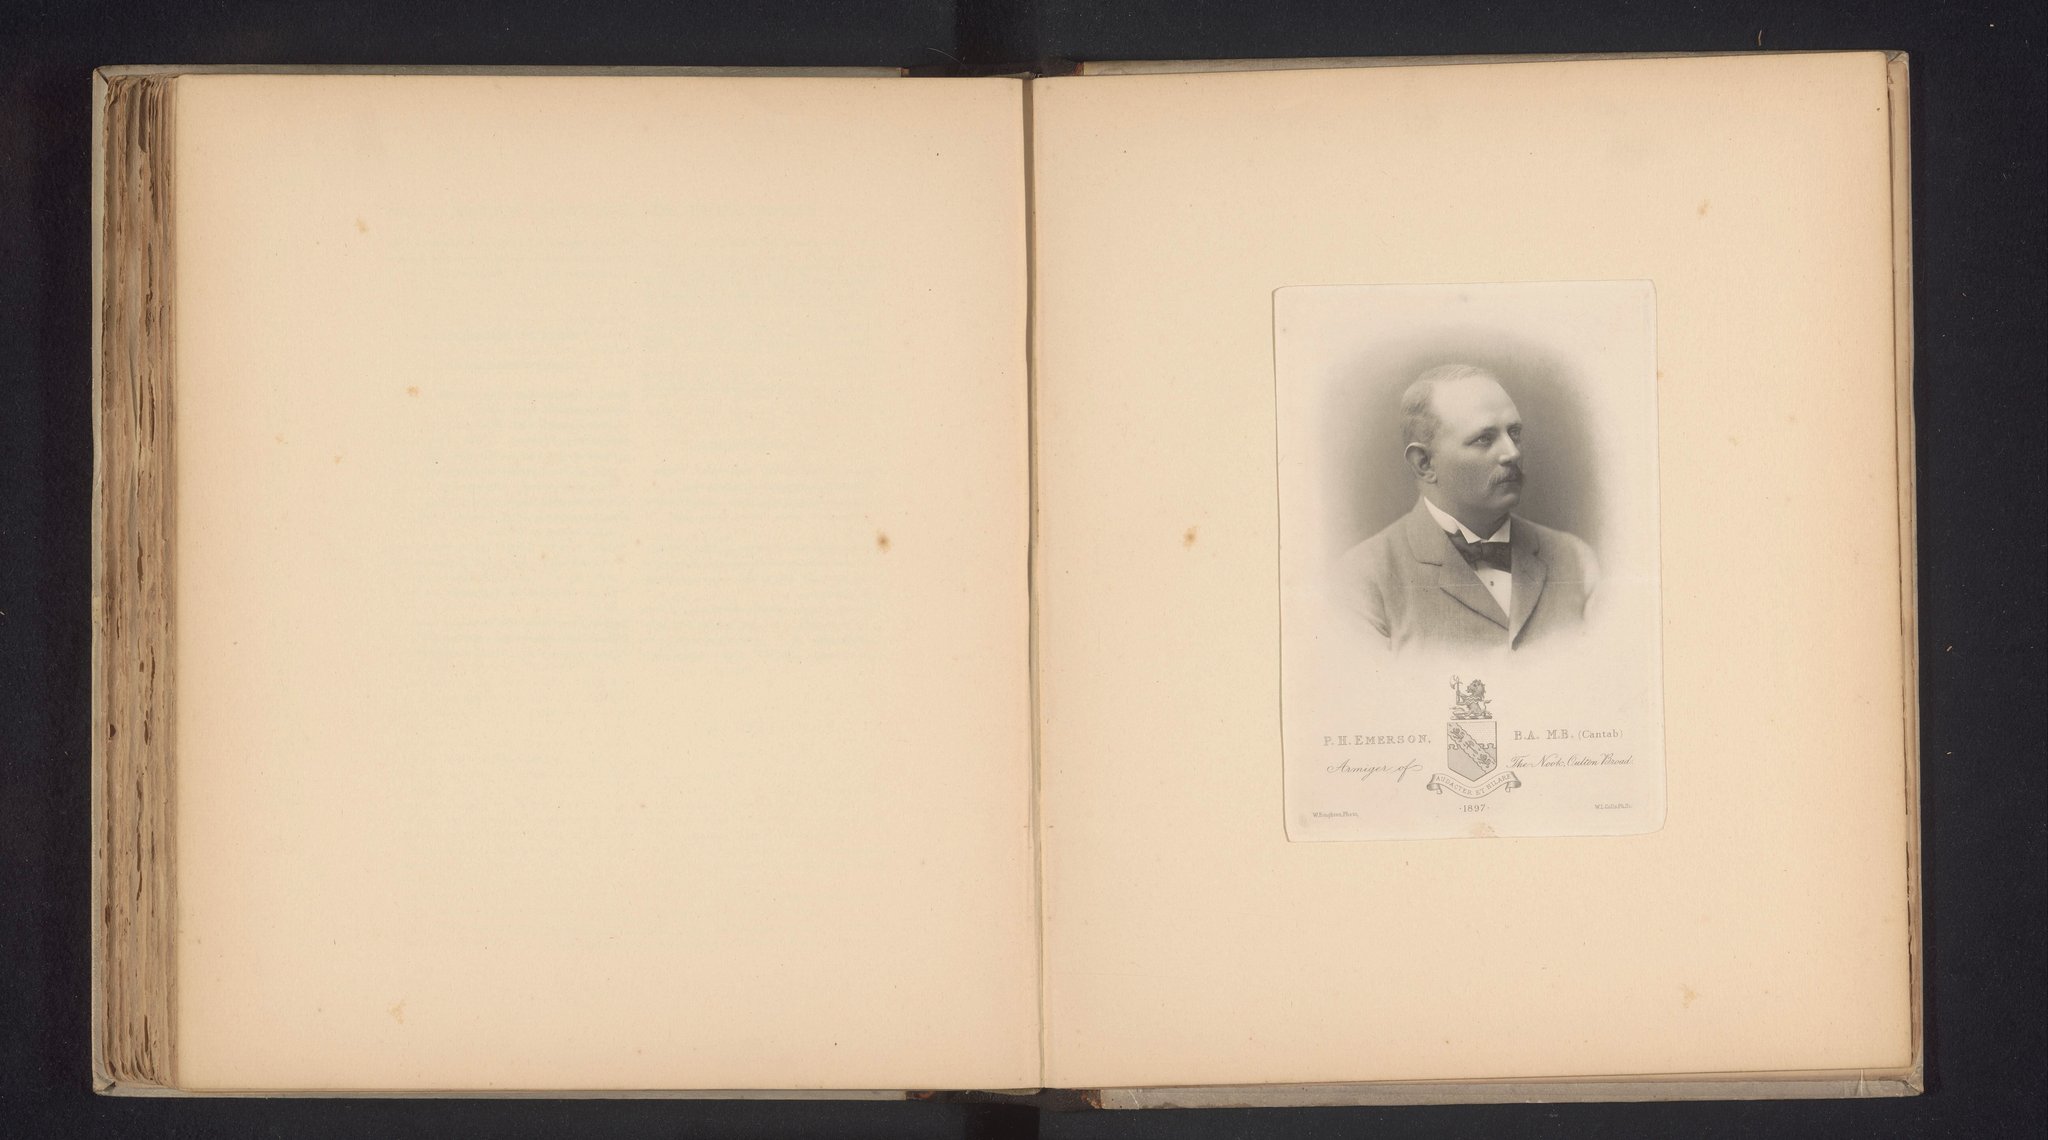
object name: page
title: P.H. Emerson, B.A. M.B.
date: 1897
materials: paper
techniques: photoaquatint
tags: peter henry emerson, portrait, self-portrait of photographer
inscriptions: inscription: ‘Armiger of The Nook, Oulton Broad’